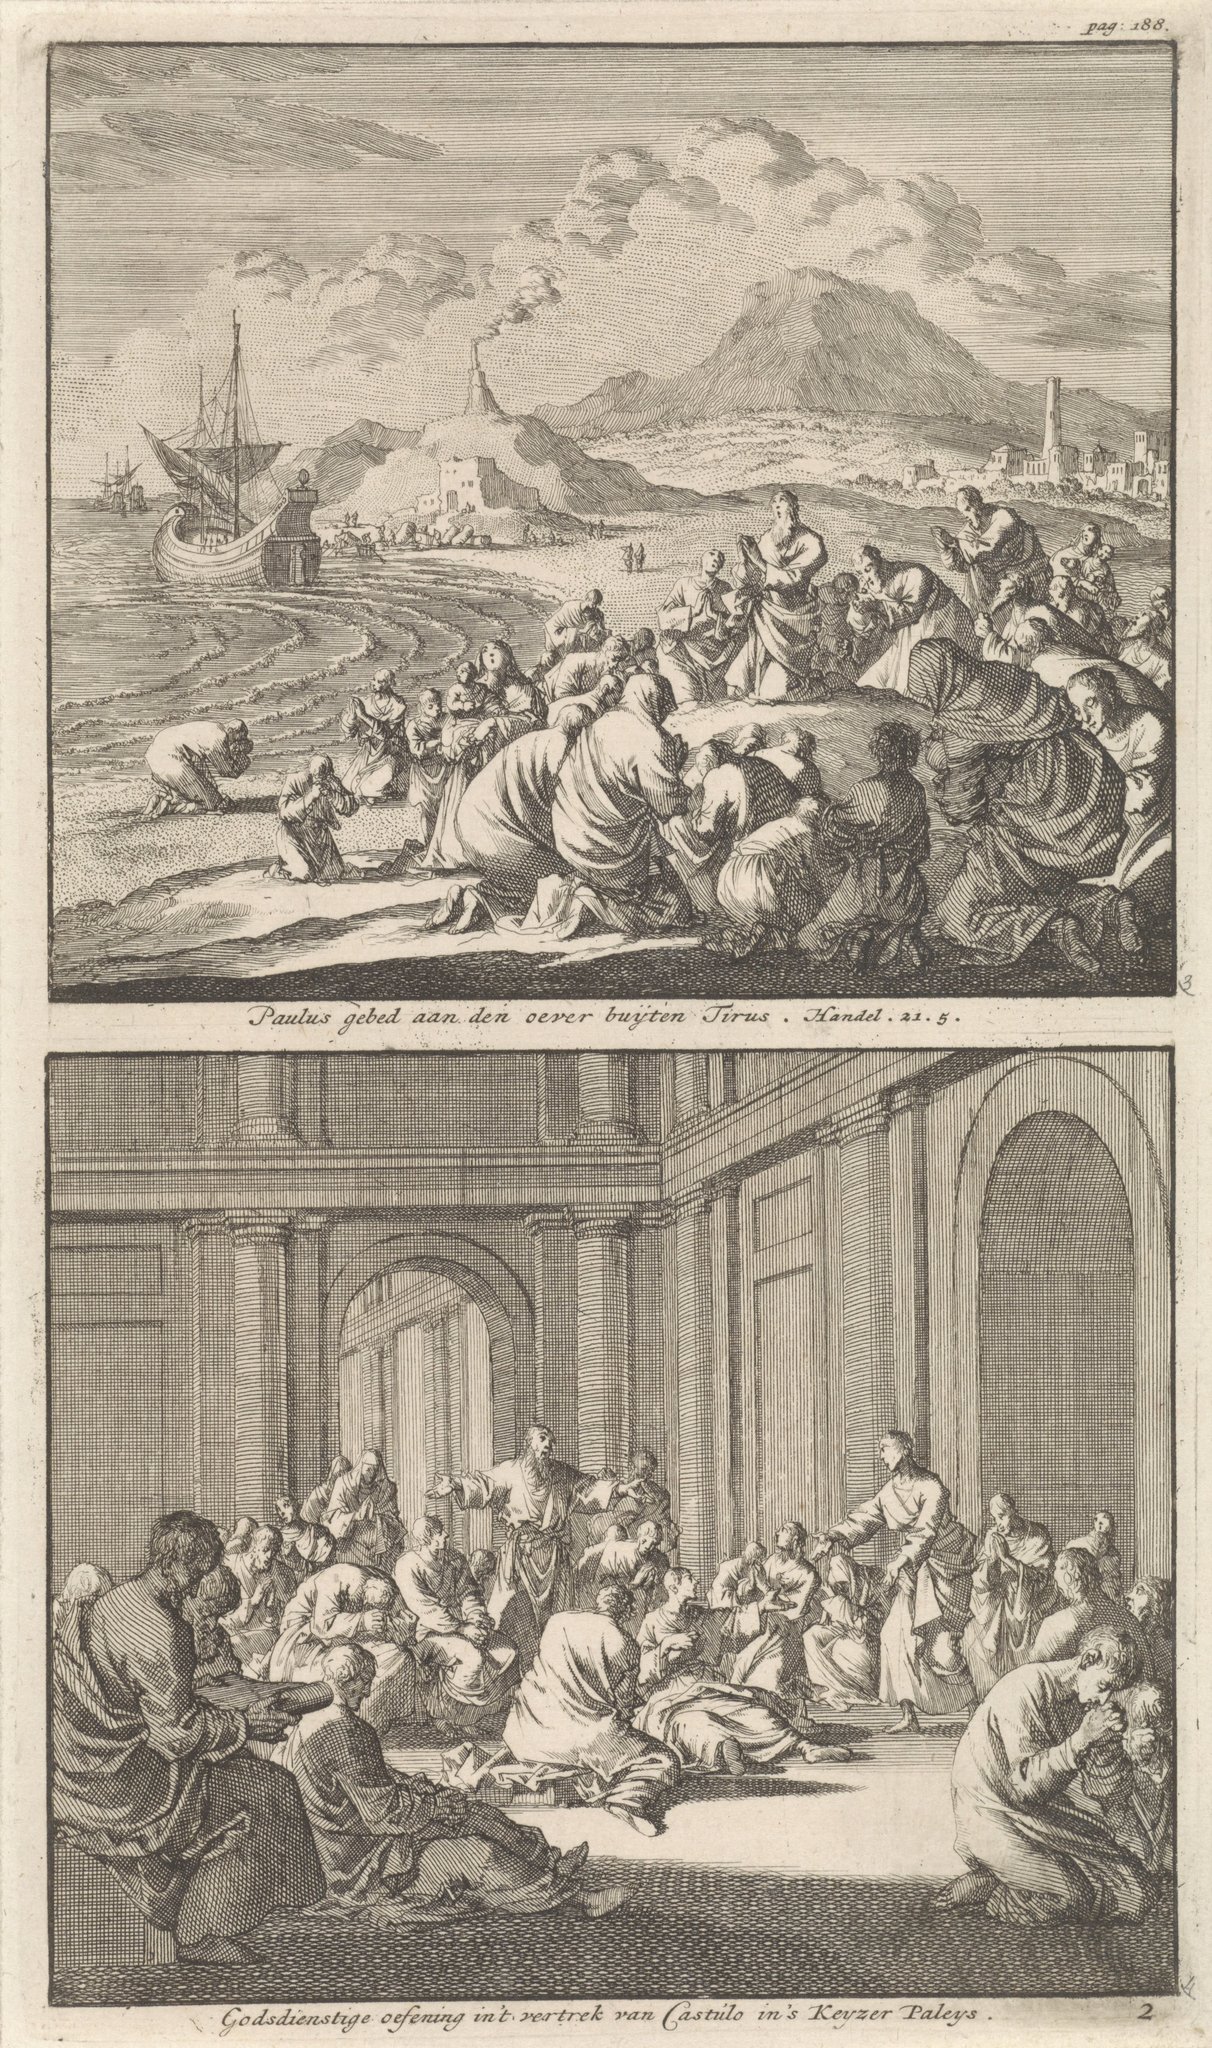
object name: print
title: Paulus gebed aan den oever buijten Tirus / Godsdienstige oefening in 't vertrek van Castulo in's Keyzer Paleys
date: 1700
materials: paper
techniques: etching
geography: amsterdam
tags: the early christian churches, e.g. armenians, copts, syrians, paul in tyre; prayer and leave-taking on the shore, palace, male saints (with name), meeting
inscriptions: collector's mark: Lugt 2228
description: Twee voorstellingen op een plaat. Boven: Paulus, geknield tussen een groep gelovigen op het strand van Tyrus. Op de achtergrond de stad Tyrus en een groot zeilschip. Onder: christenen vergaderen in het keizerlijk paleis, in de privé-kamer de H. Castulus, de kamerheer van keizer Diocletianus.